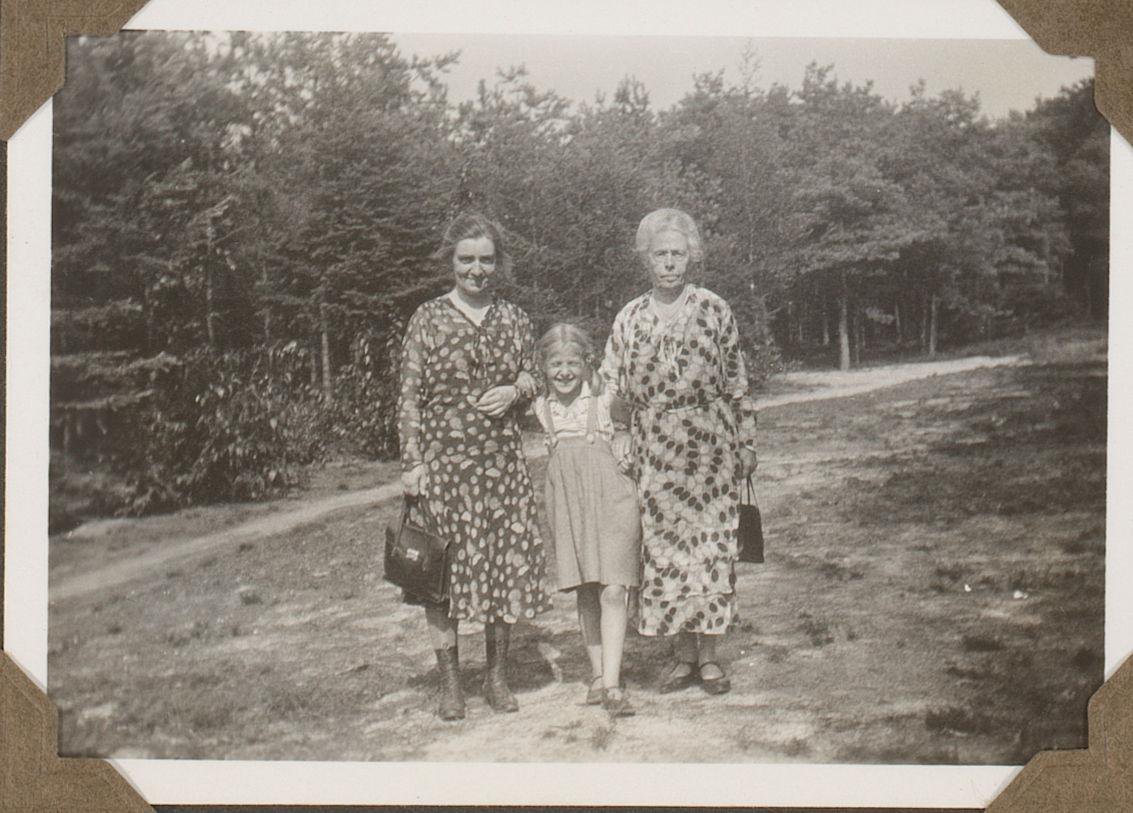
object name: album leaf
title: Portret van twee vrouwen en een meisje tussen hen in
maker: Anonymous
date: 1920-1930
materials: photographic support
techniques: gelatin silver print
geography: netherlands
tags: historical persons, girl (child between toddler and youth), adult woman (+ two persons)